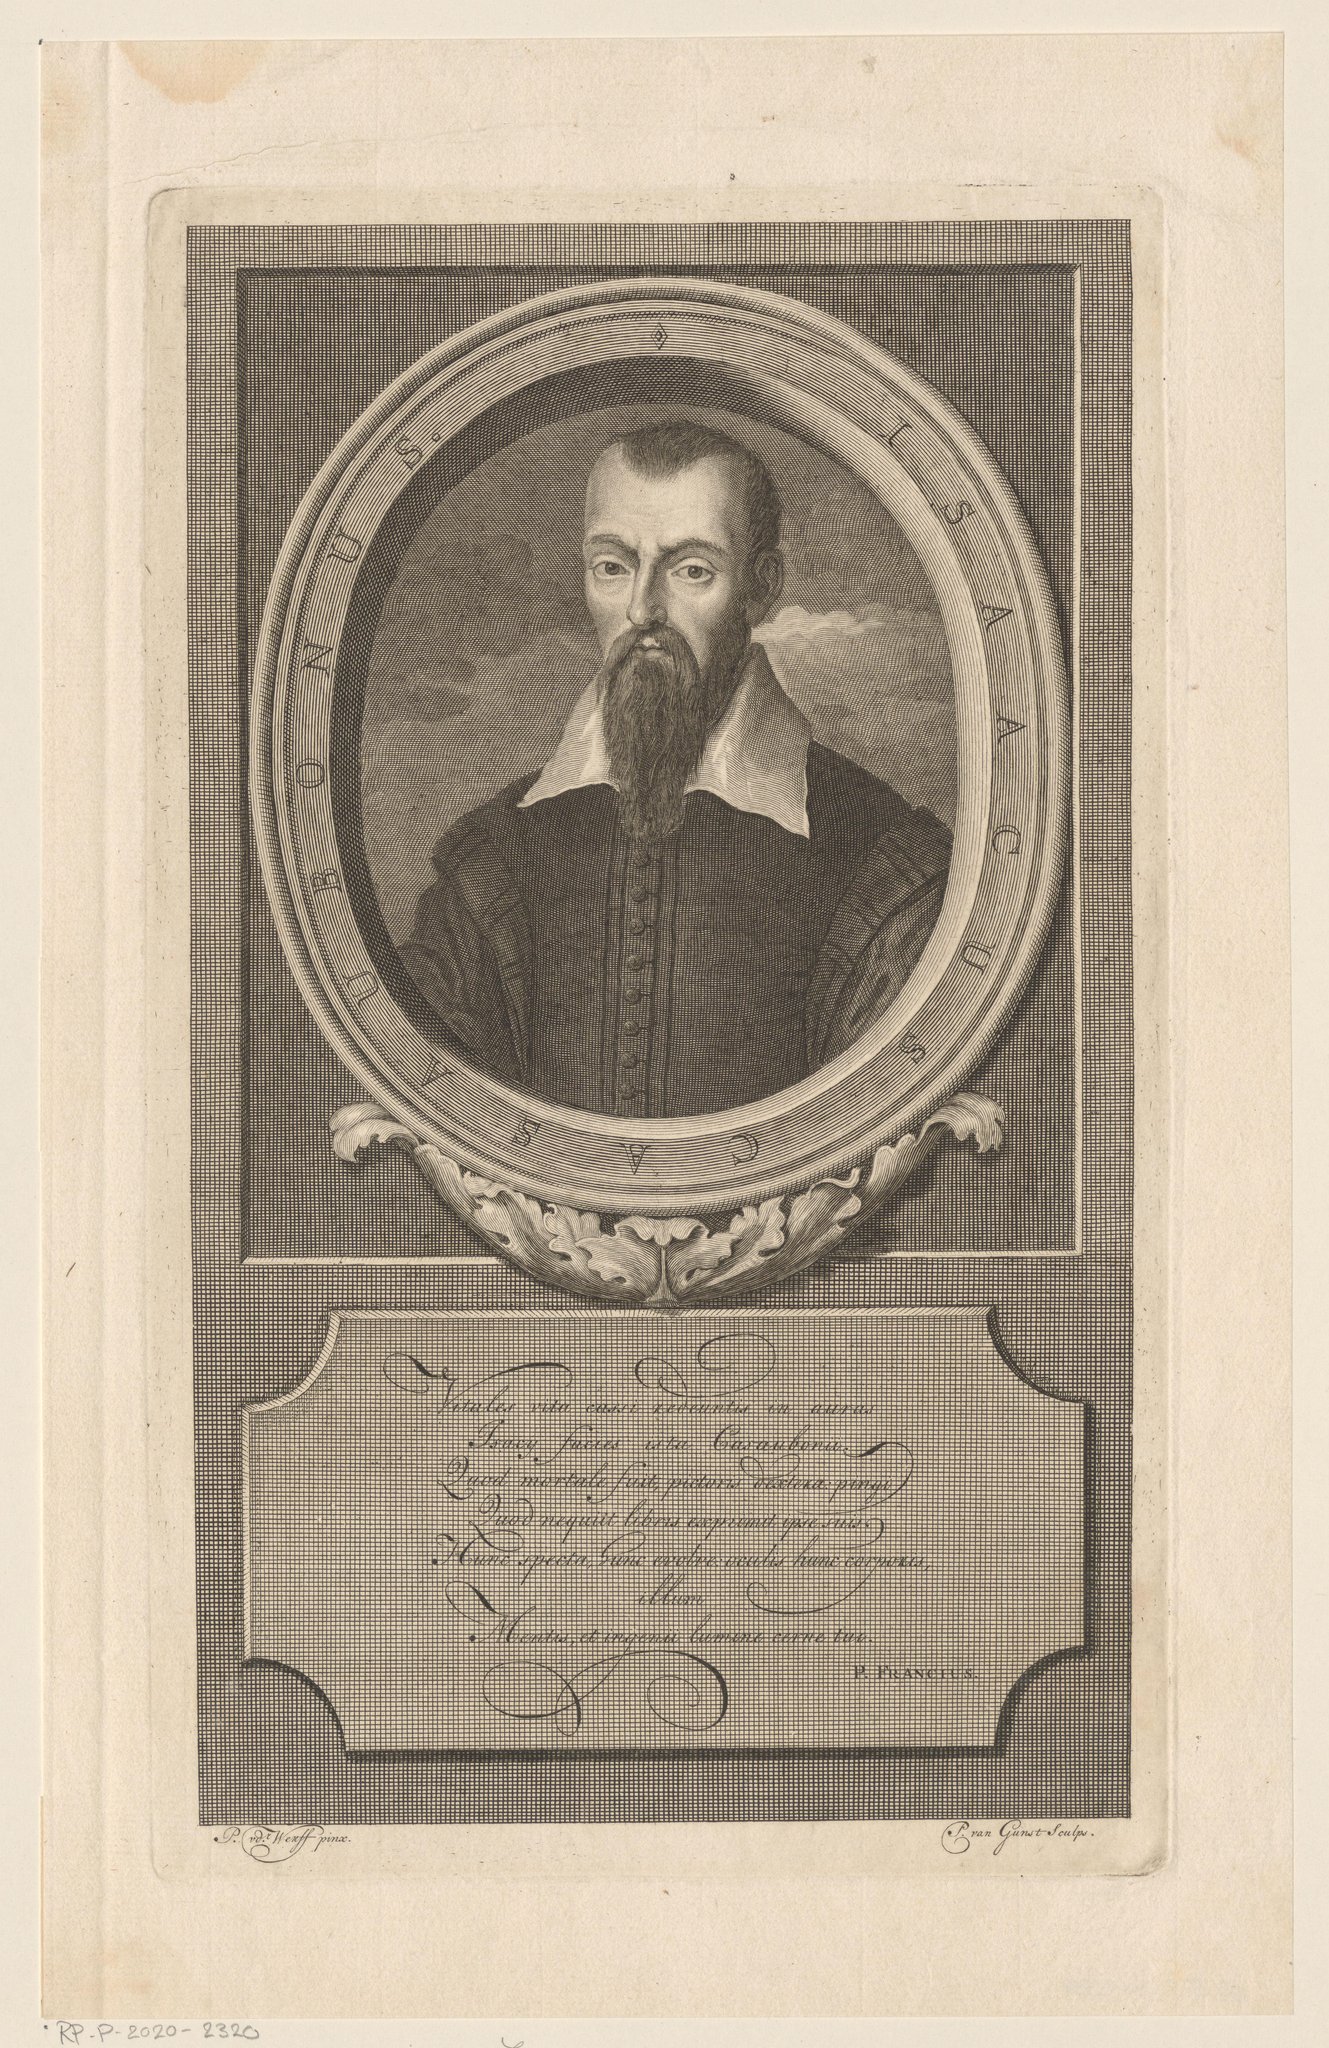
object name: print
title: Portret van Isaac Casaubon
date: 1709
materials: paper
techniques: engraving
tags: historical persons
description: Prent mogelijk uit: Casaubon, Isaac, en Mericus Casaubon. Isaaci Casauboni epistolæ (...). Rotterdam: Caspar Fritsch en Michael Böhm, 1709.